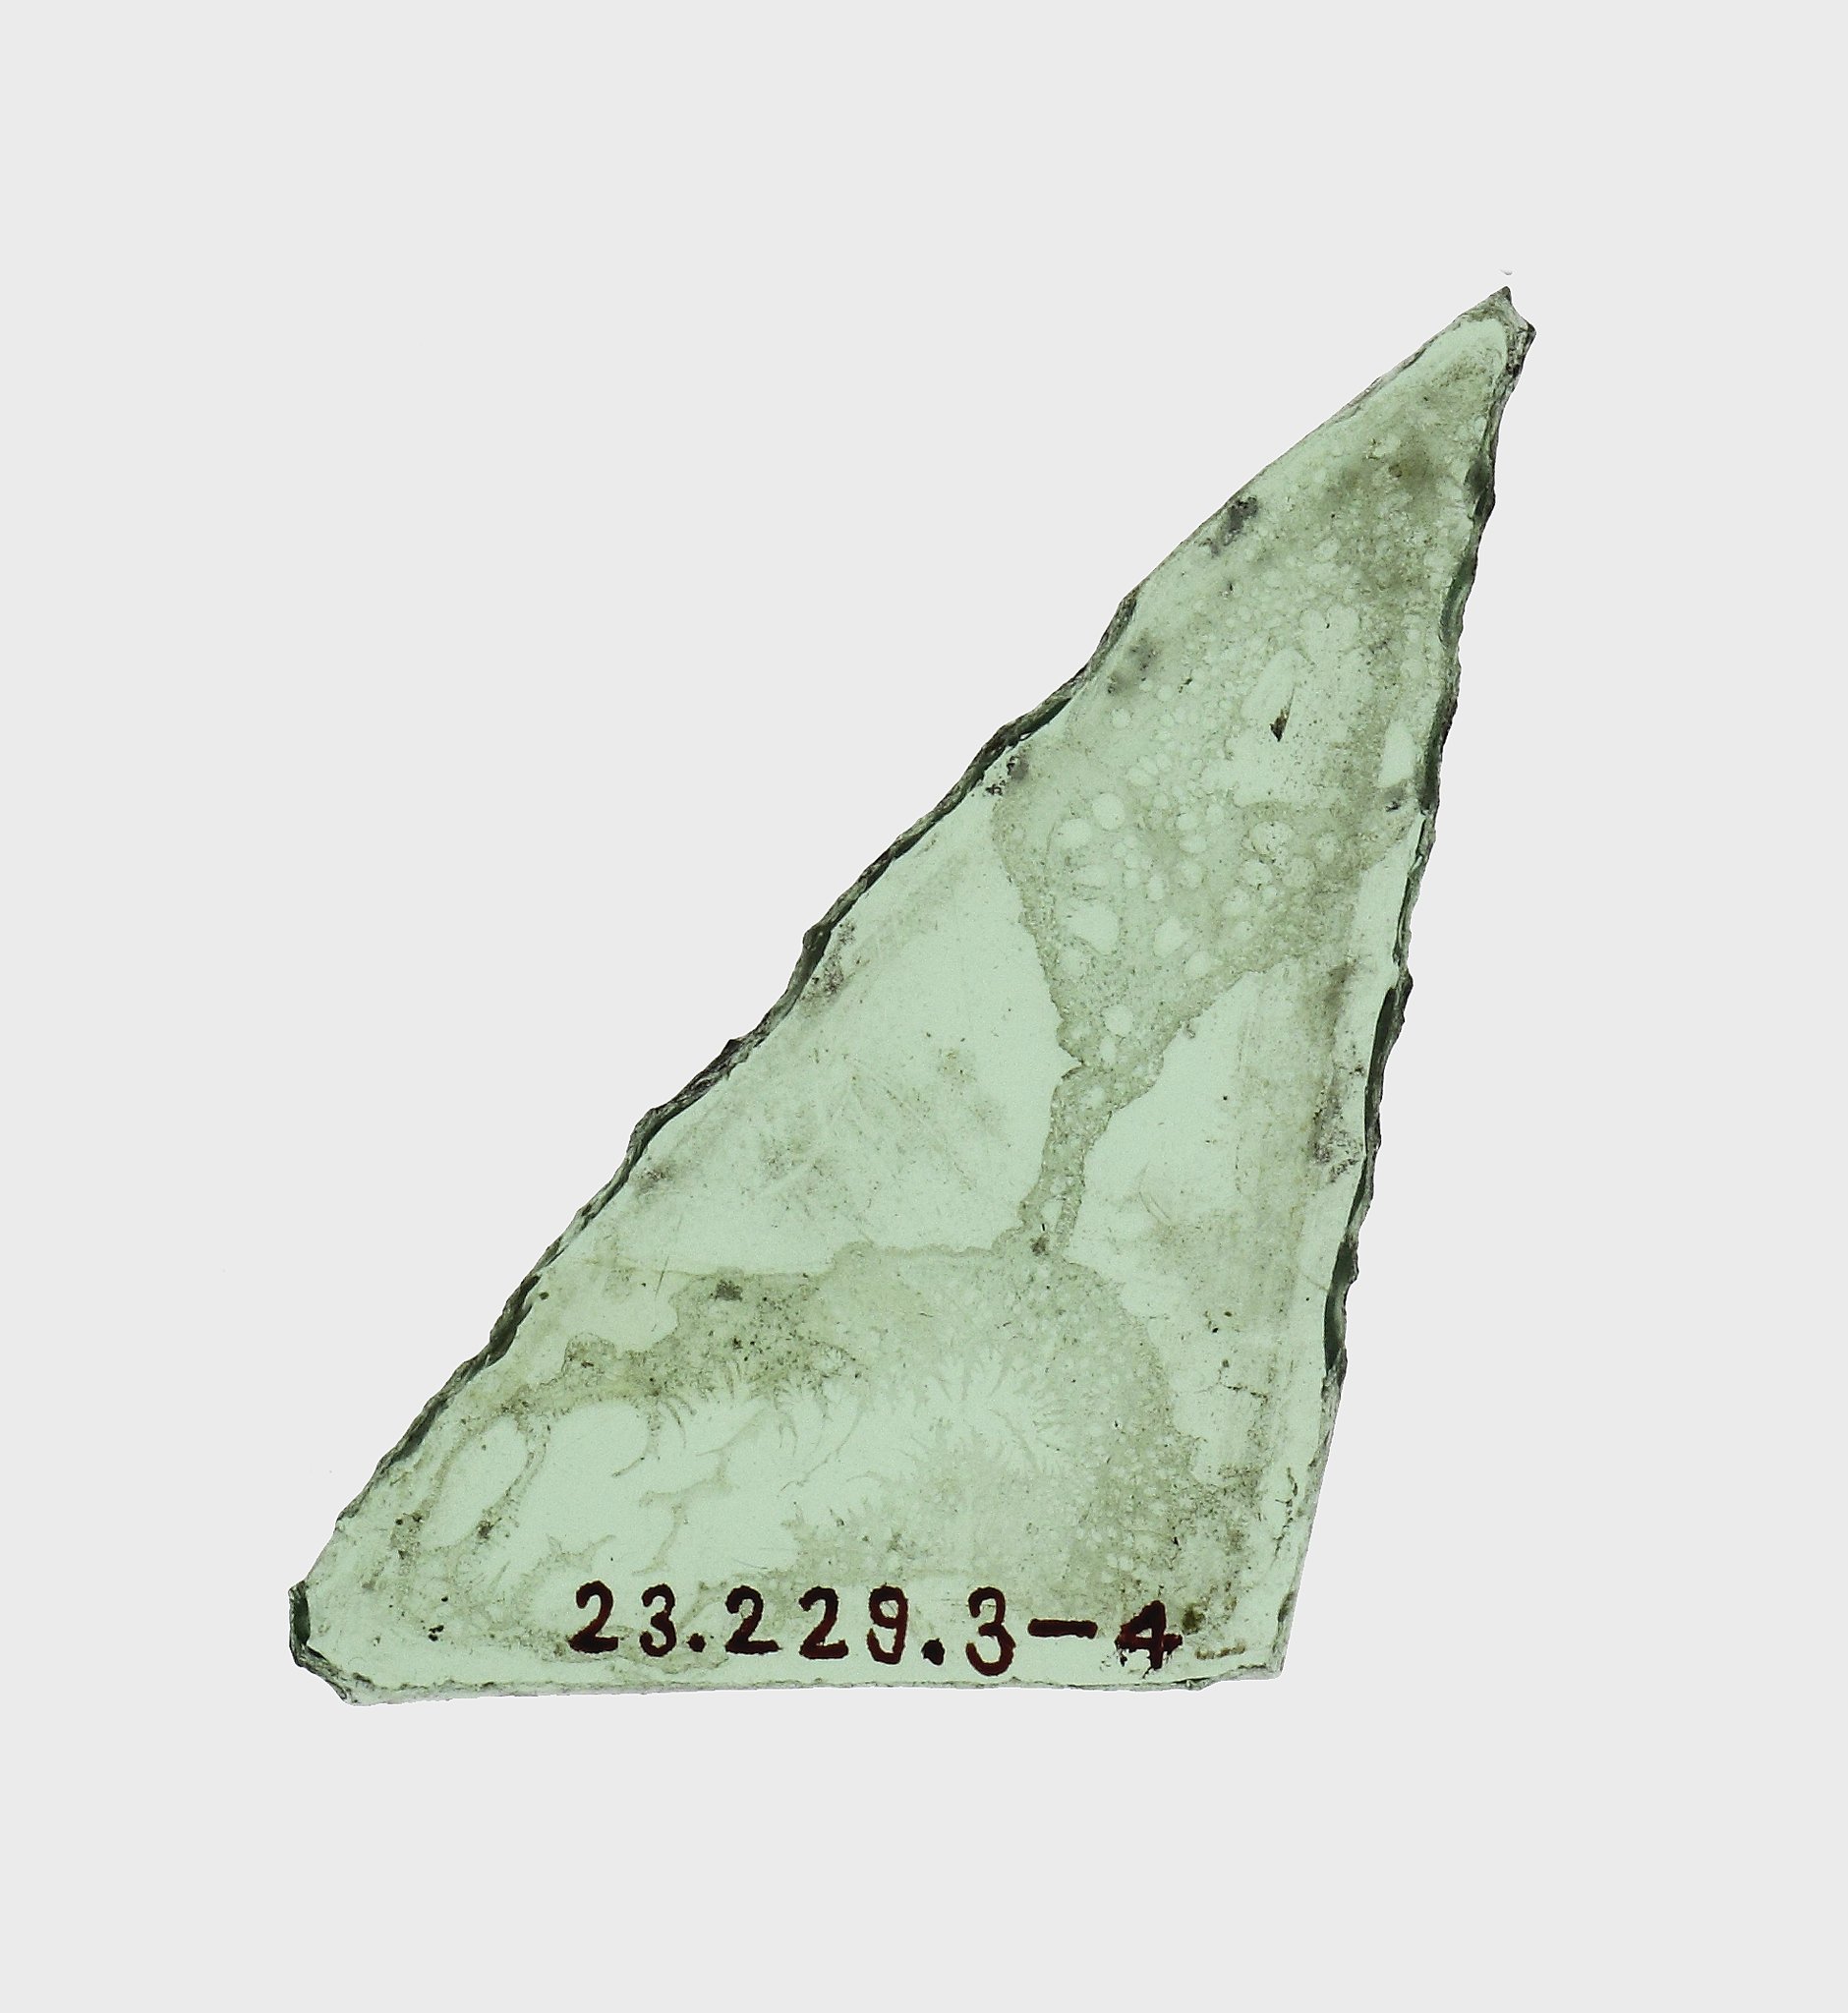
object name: fragment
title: Glass Fragment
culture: dutch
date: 1701-1800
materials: glass